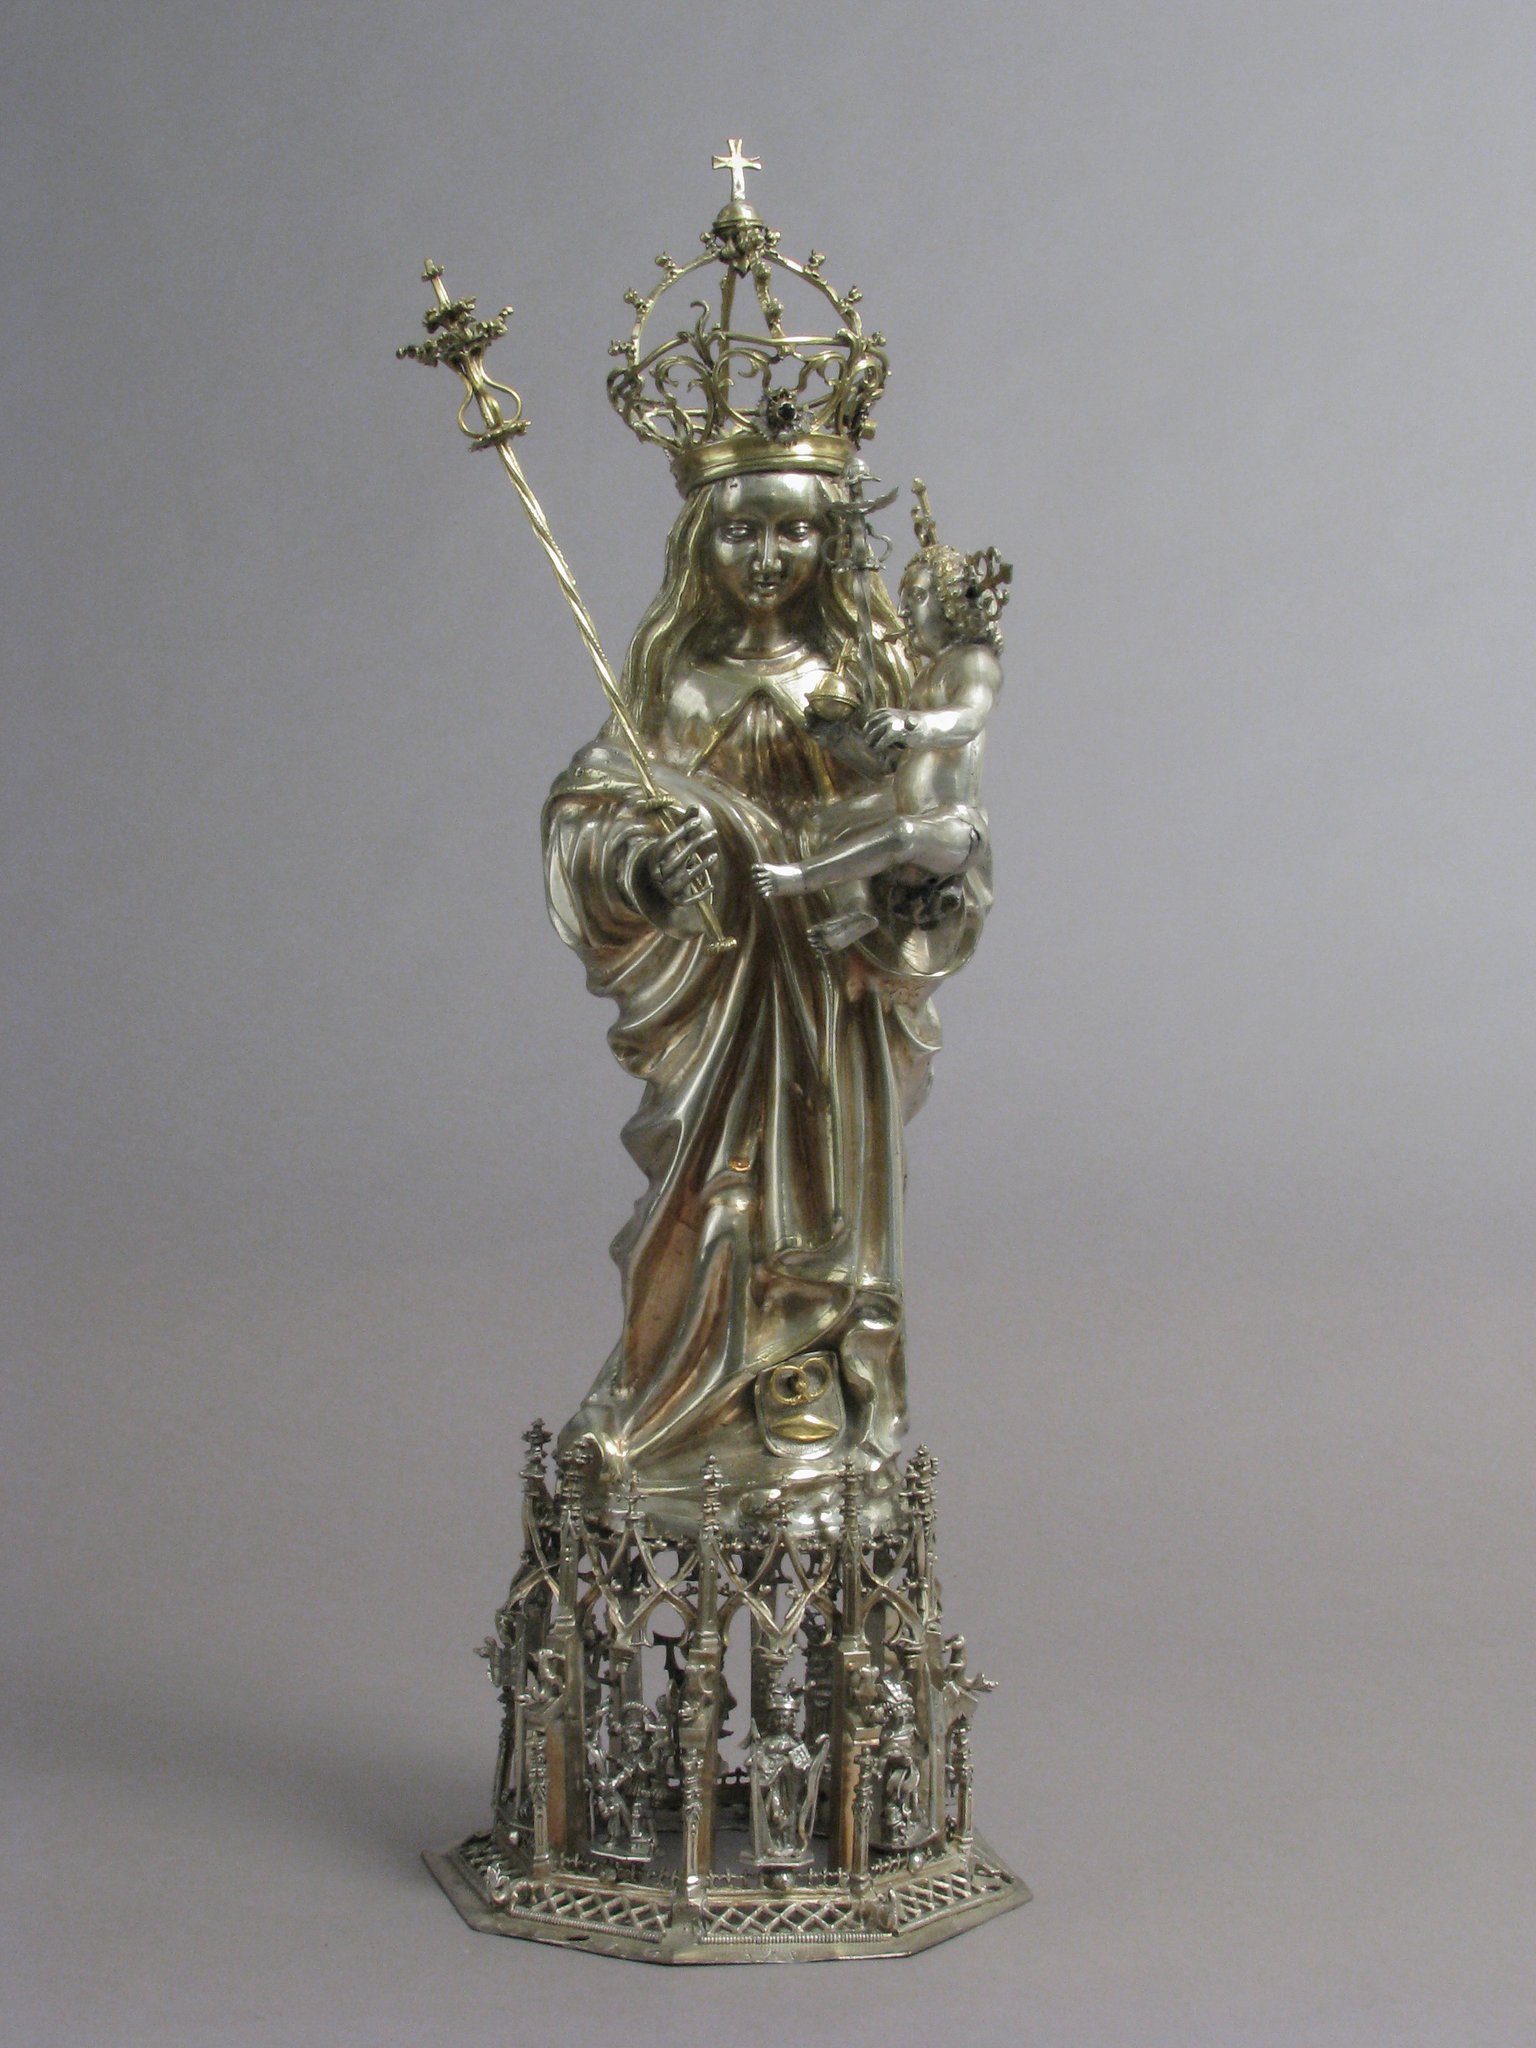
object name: statuette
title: Standing Virgin and Child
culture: german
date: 1801-1900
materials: silver, silver gilt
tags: virgin mary,cross,jesus